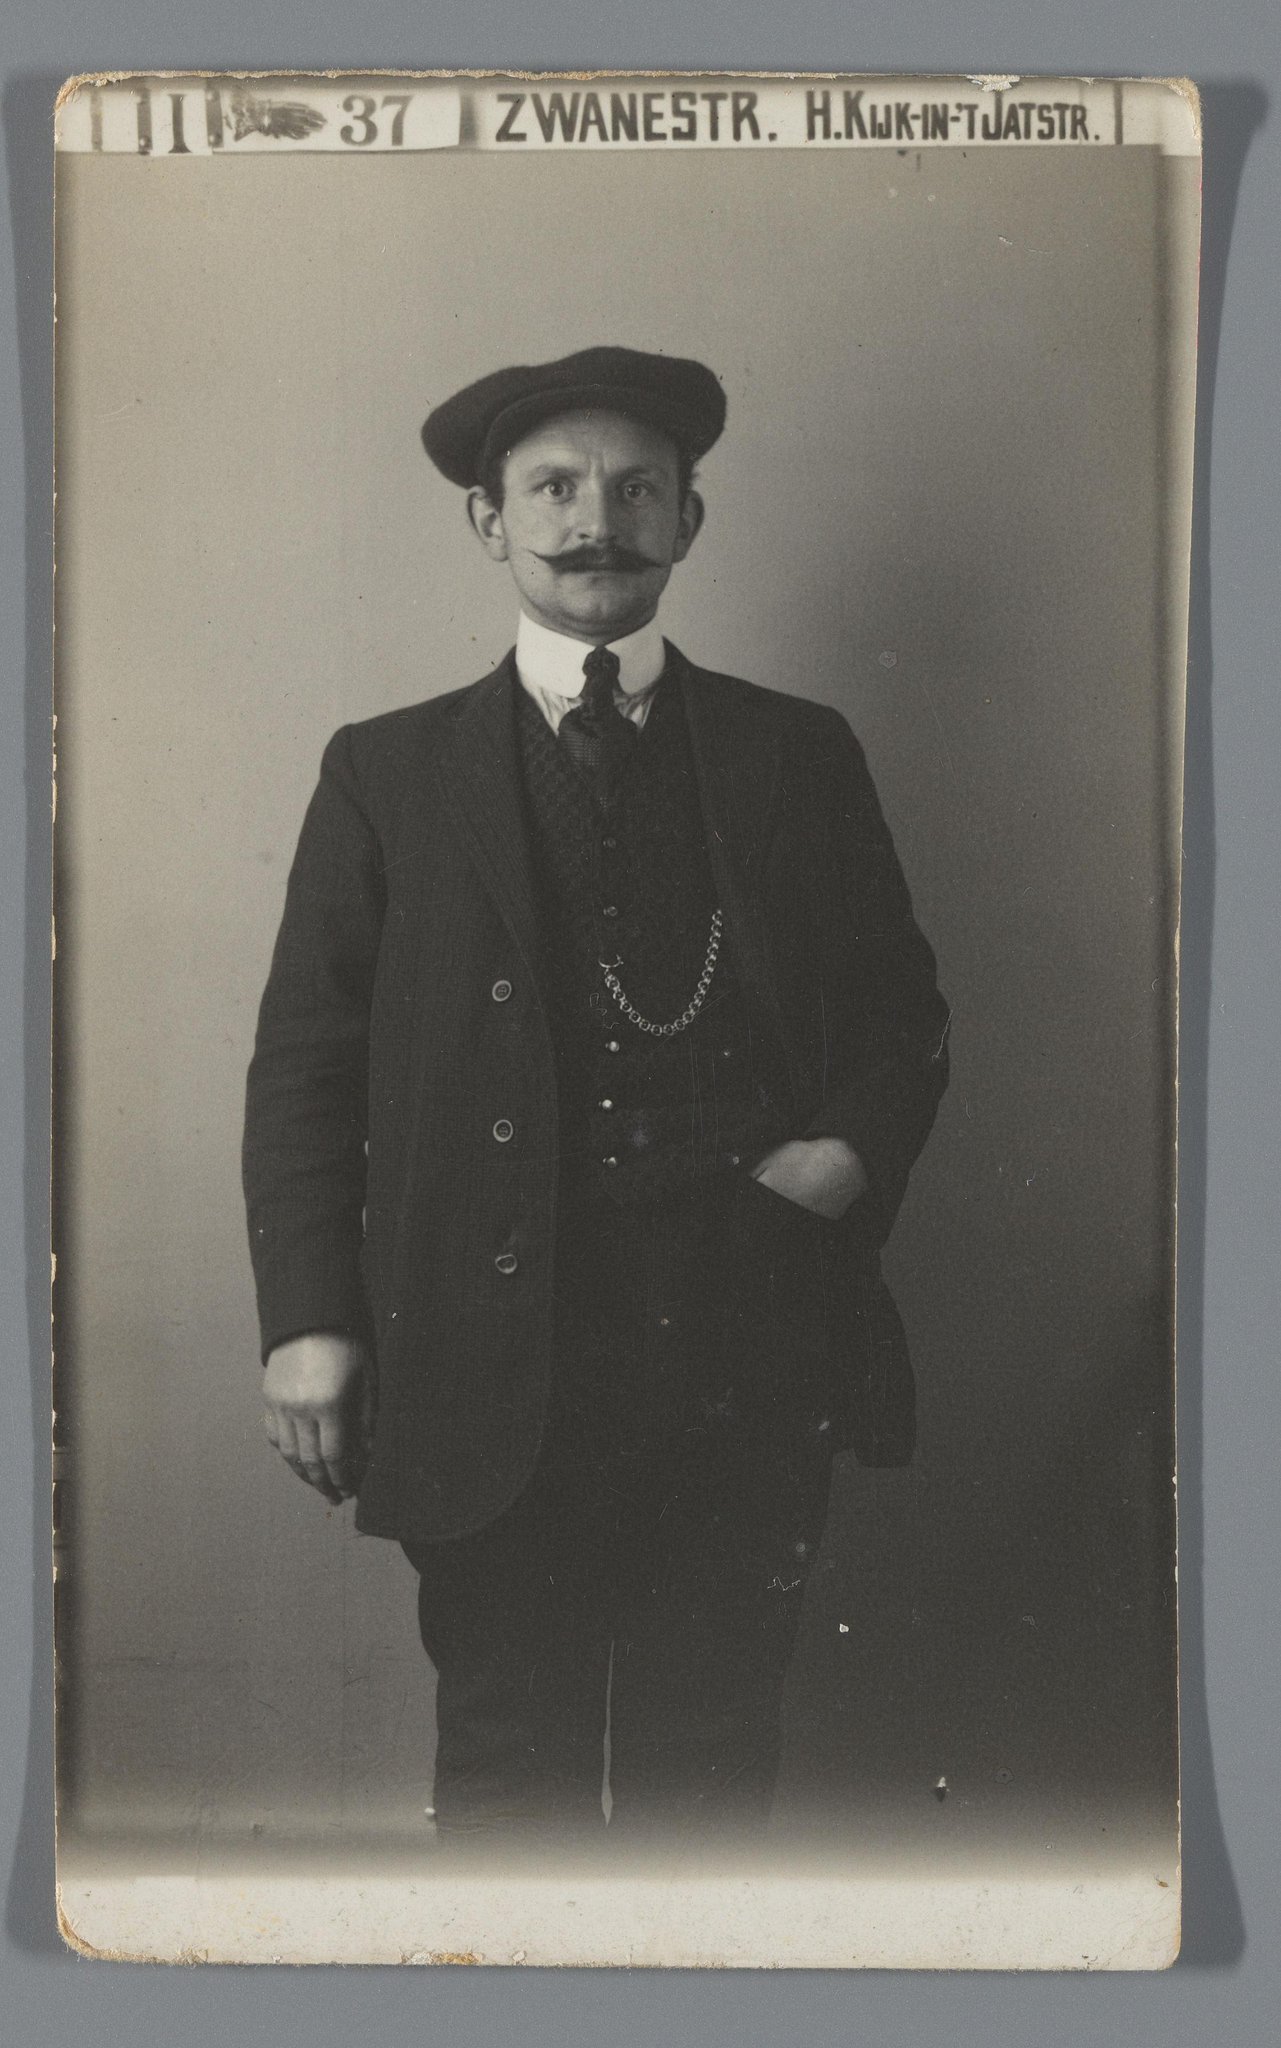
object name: snapshot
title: Portret van een man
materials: photographic support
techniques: gelatin silver print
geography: groningen